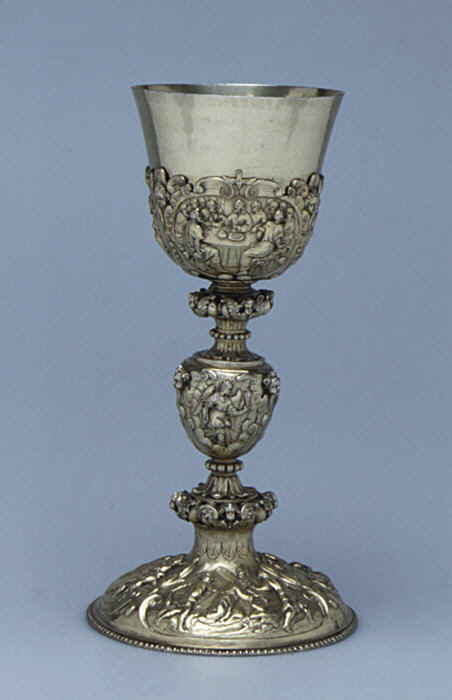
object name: chalice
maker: adam pijart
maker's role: maker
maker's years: 1579-1679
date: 1625-1626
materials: gilt silver